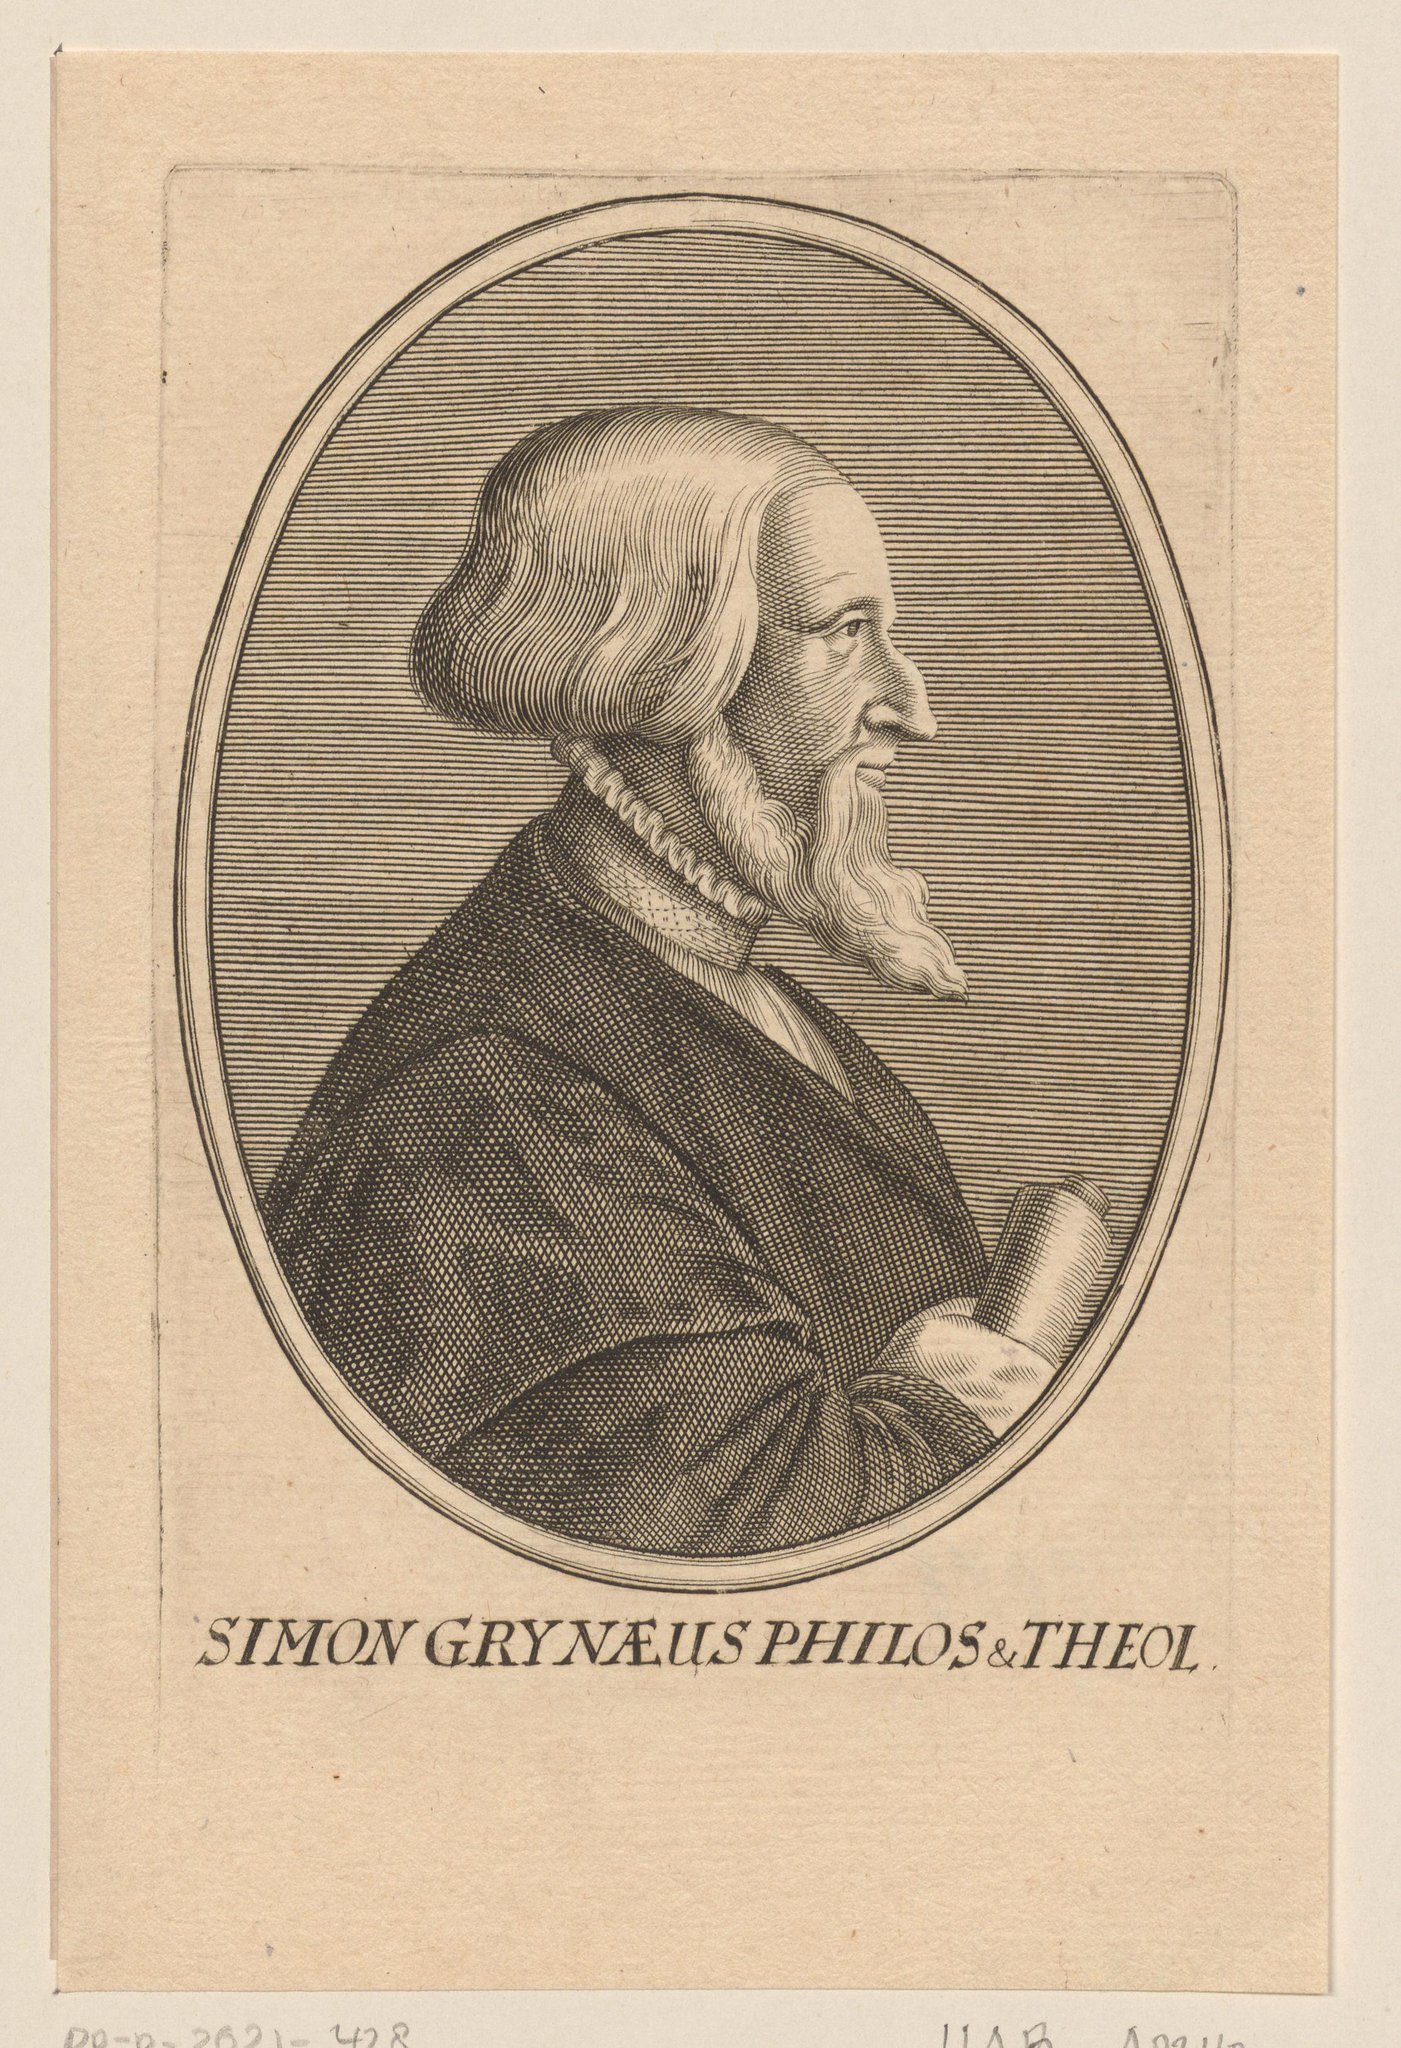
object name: print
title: Portret van Simon Grynaeus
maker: Anonymous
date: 1700-1800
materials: paper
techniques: engraving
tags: theologian, historical persons